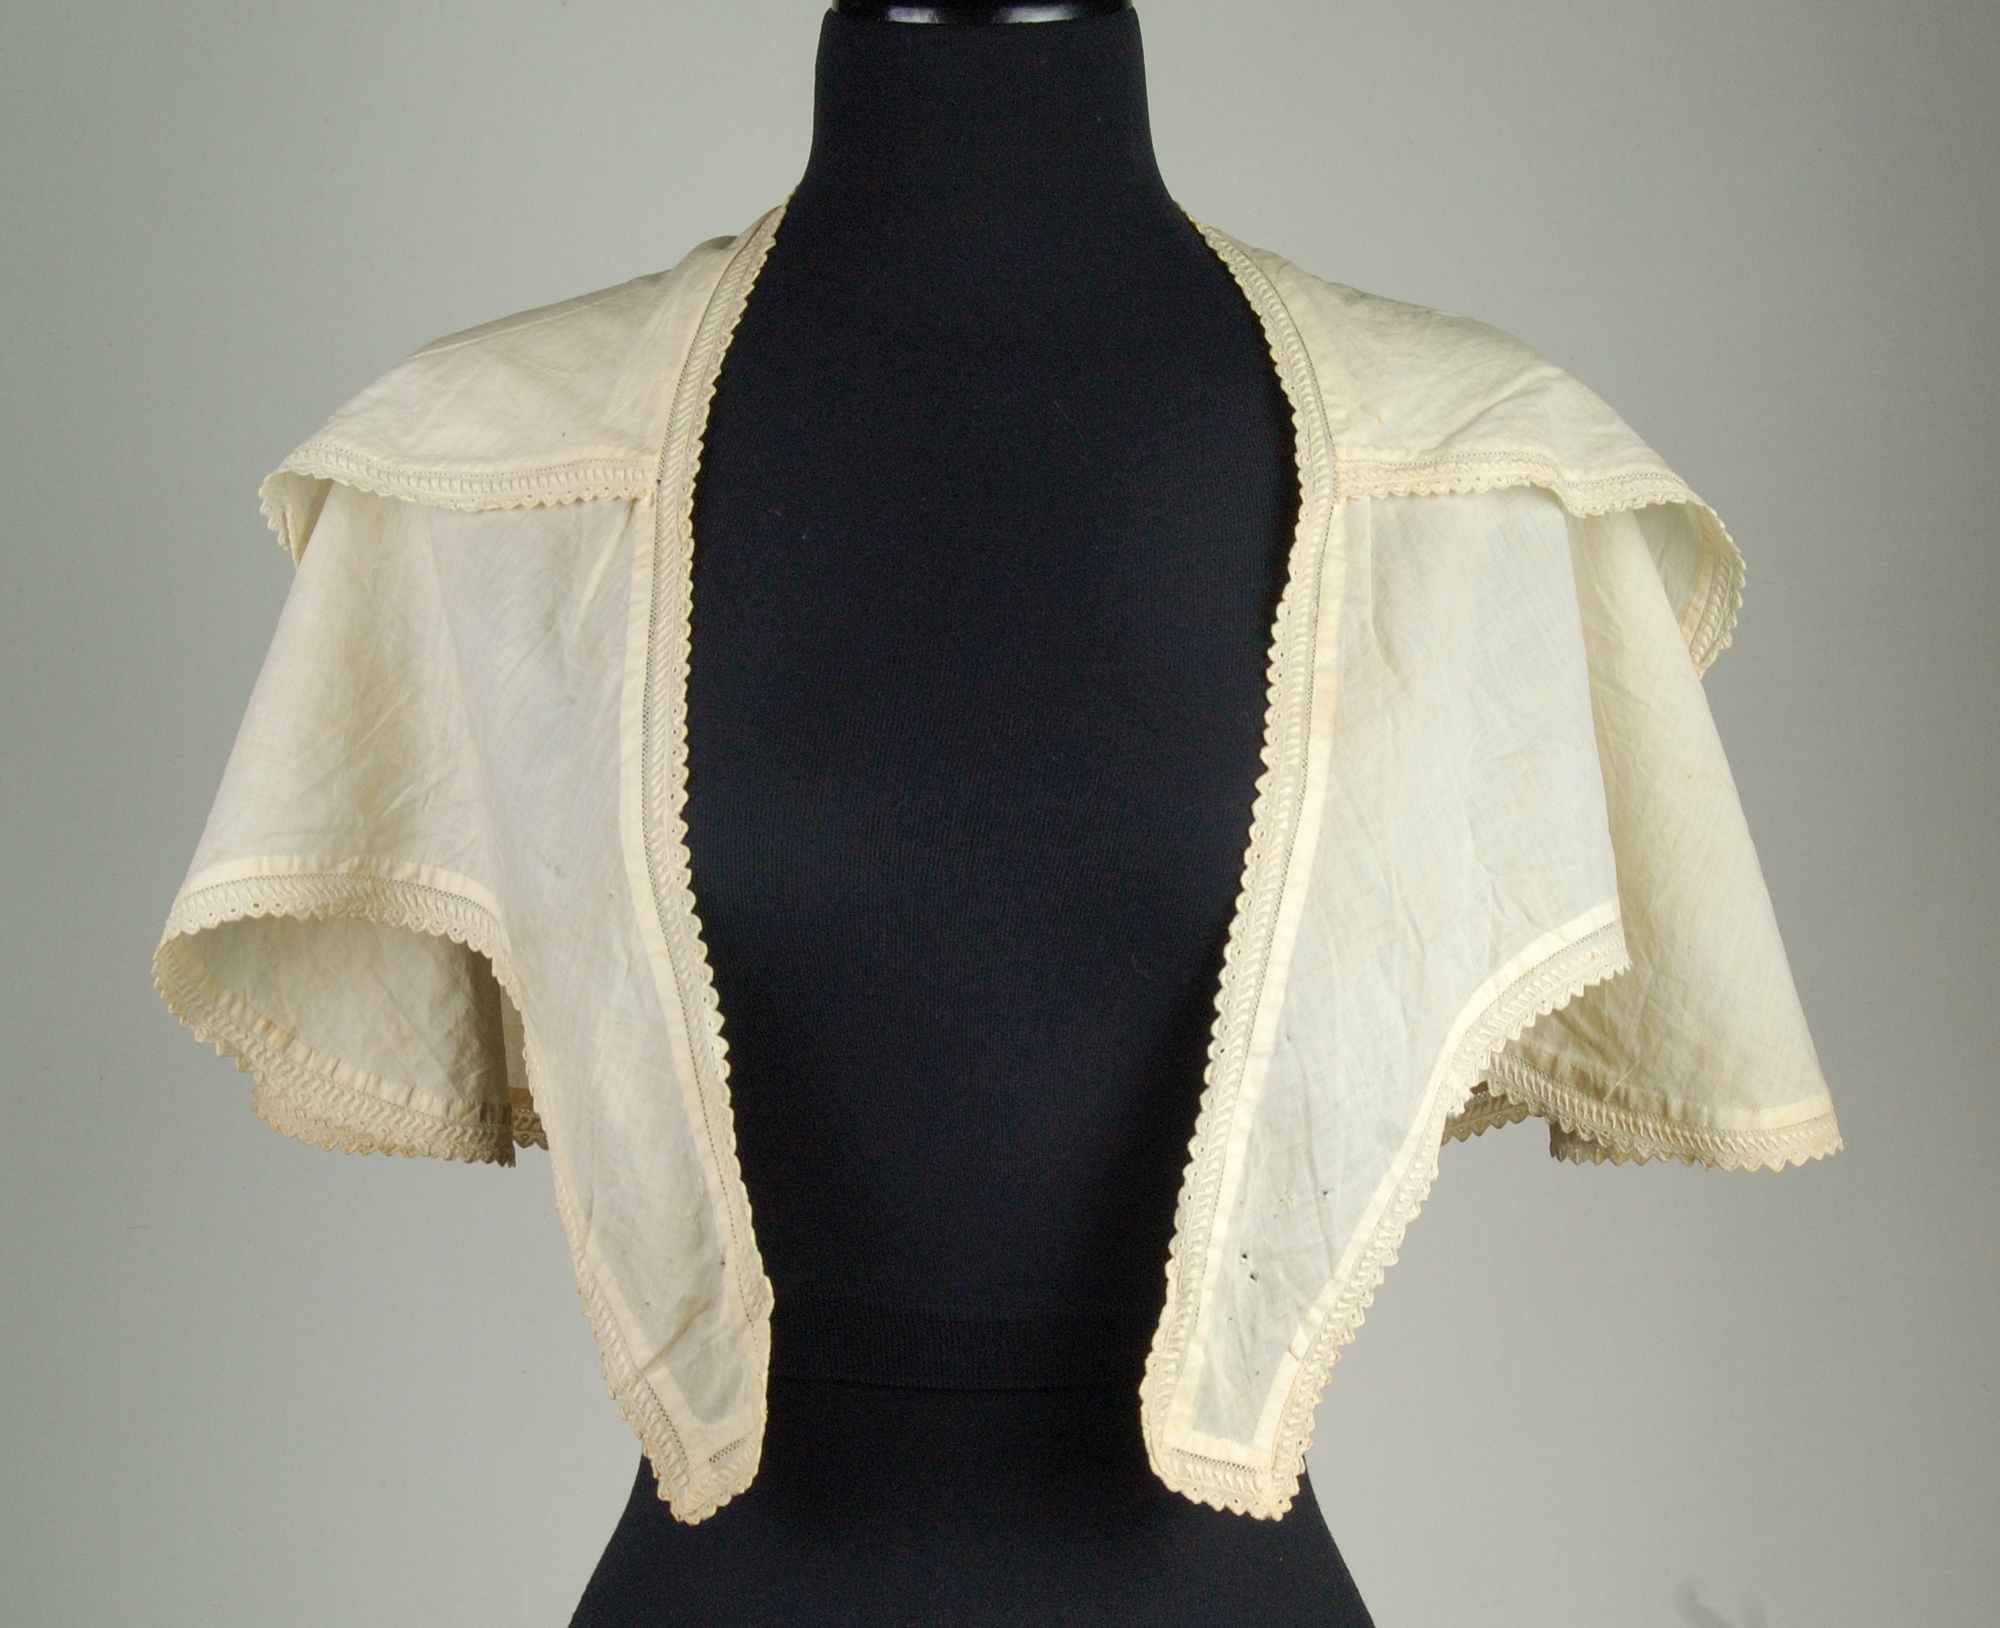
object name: pelerine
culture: american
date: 1840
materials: cotton